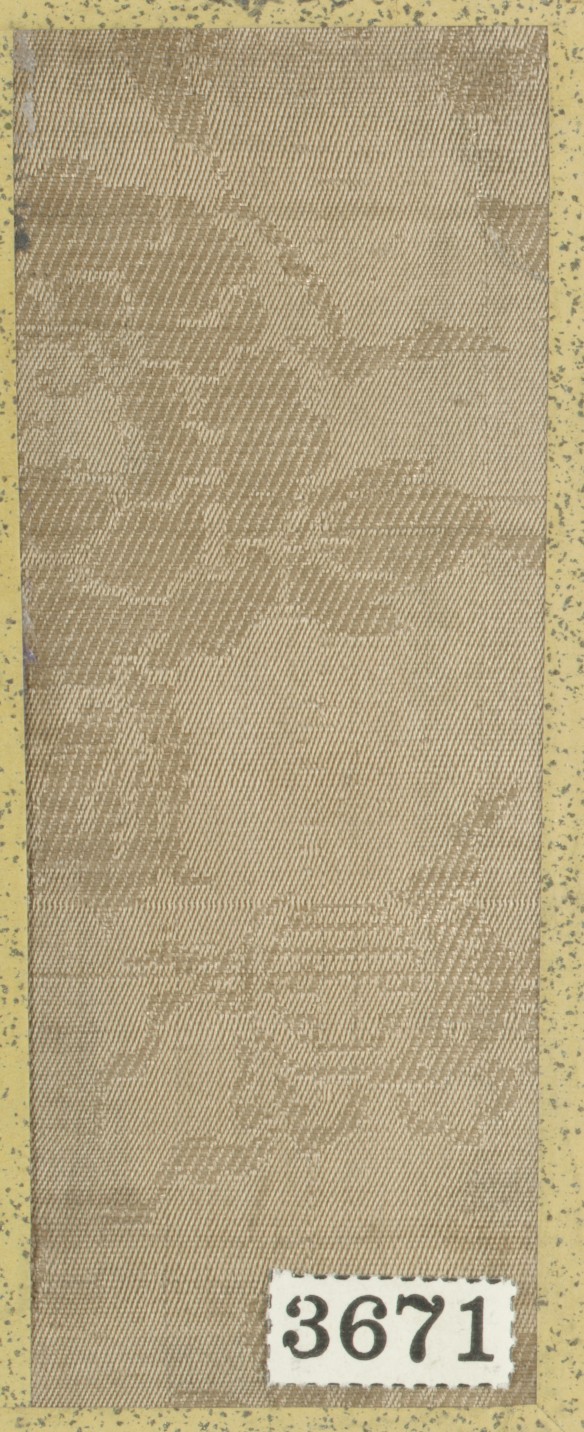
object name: sample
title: Textile Sample from Sample Book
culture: japanese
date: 1801-1900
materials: silk